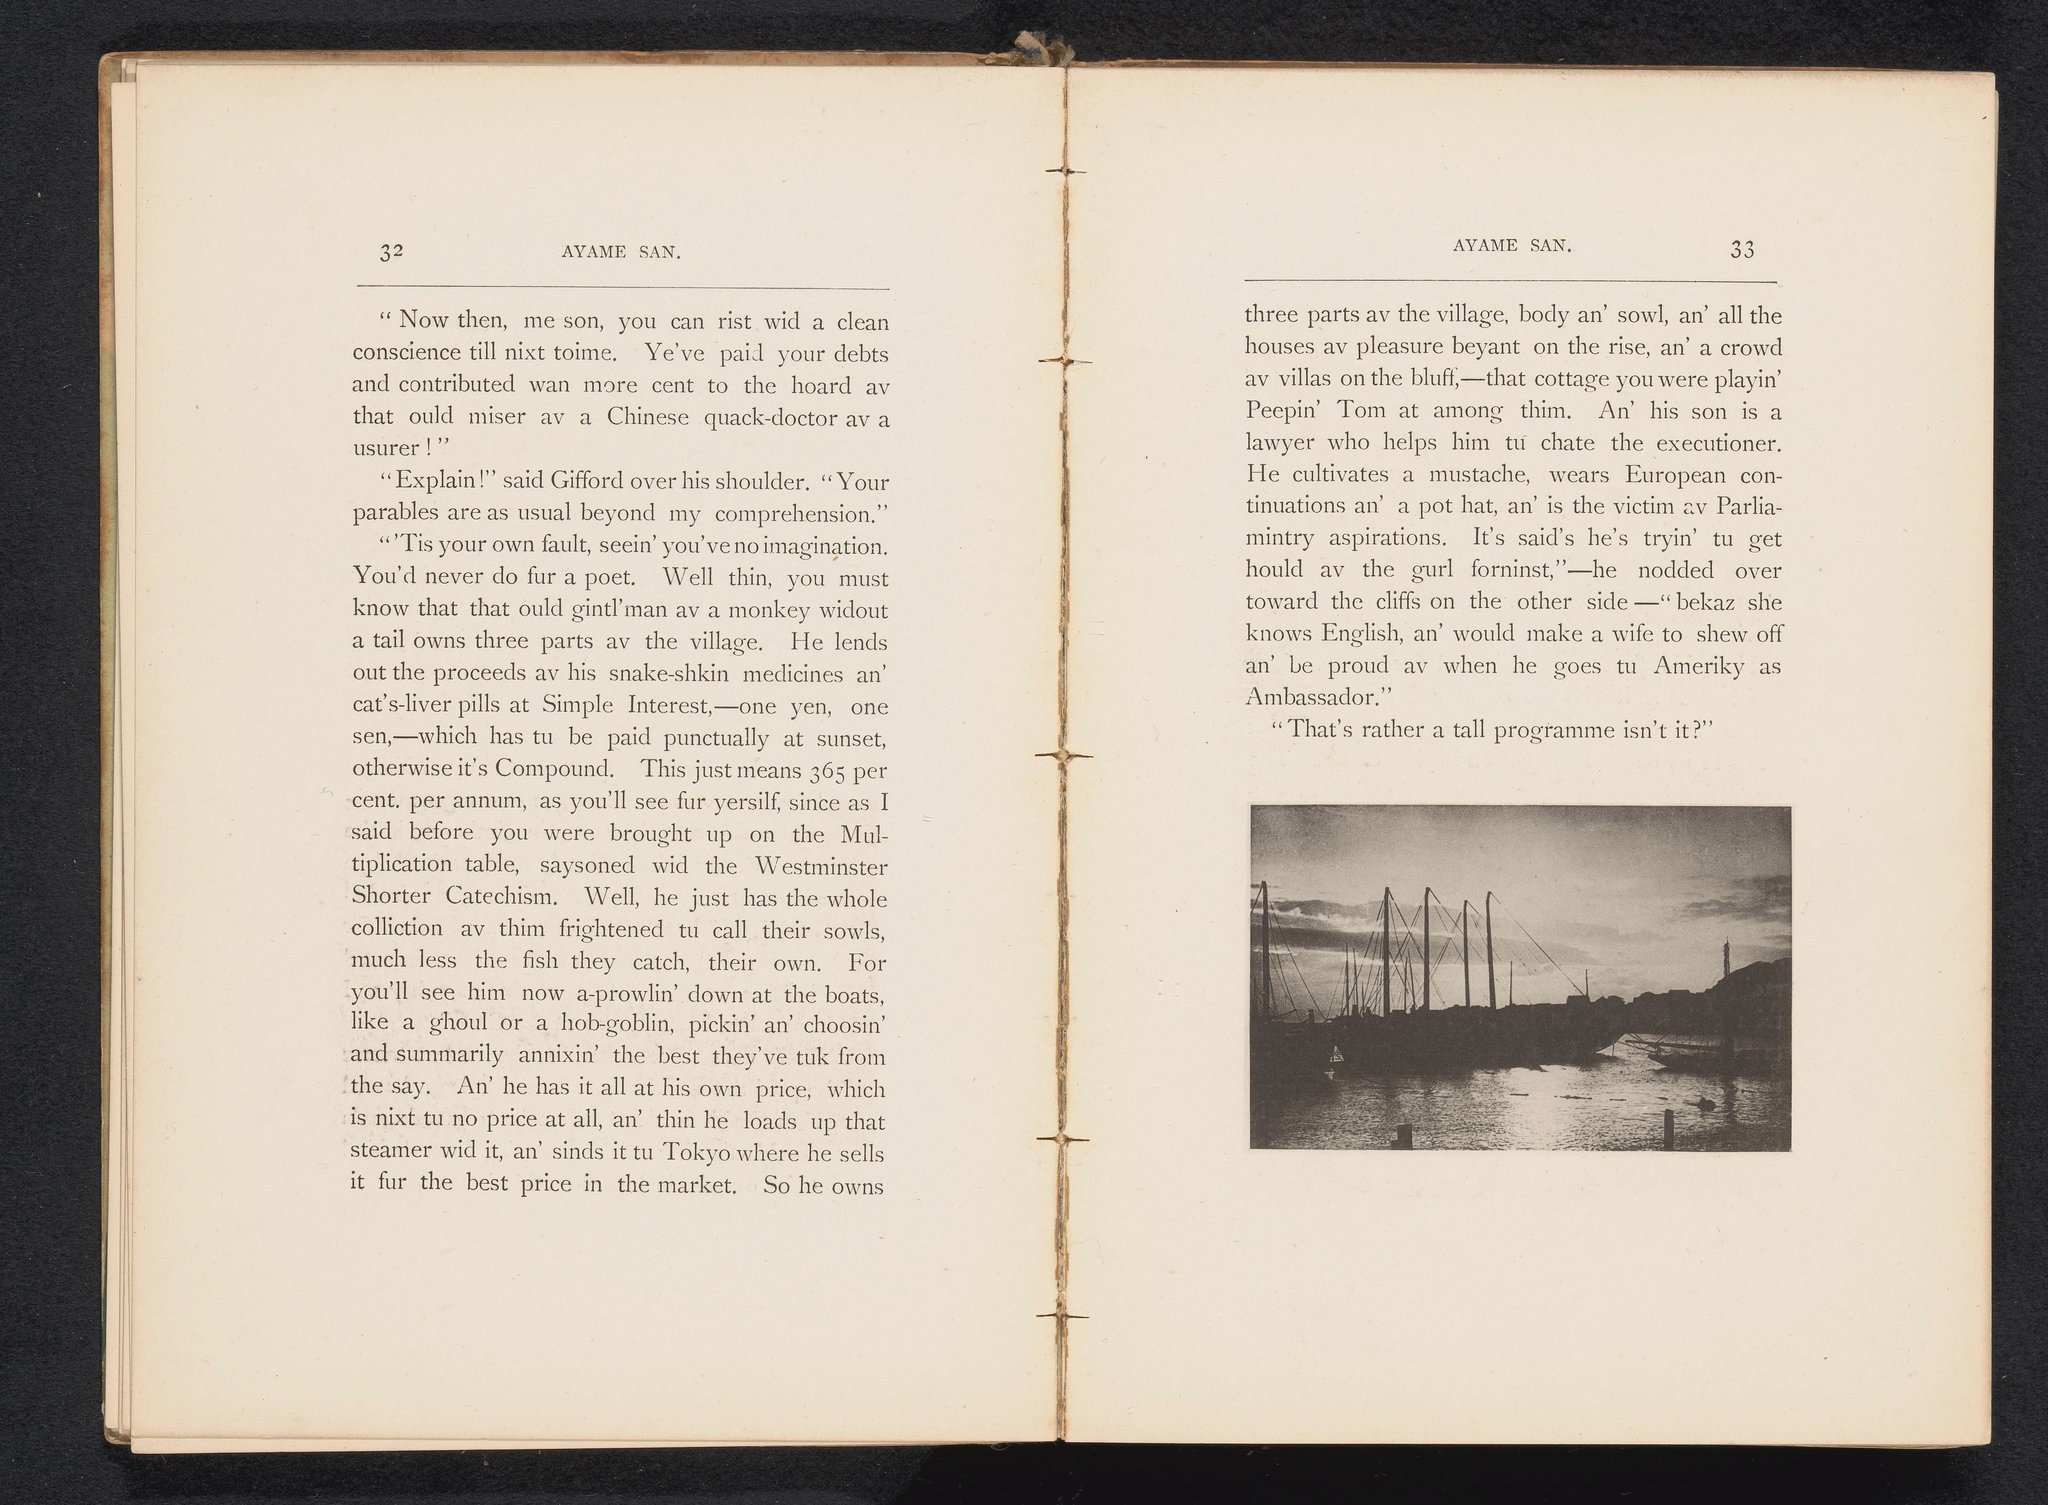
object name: page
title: Schepen in een haven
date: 1882-1892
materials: paper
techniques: photograph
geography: japan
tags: harbour, ships (in general)